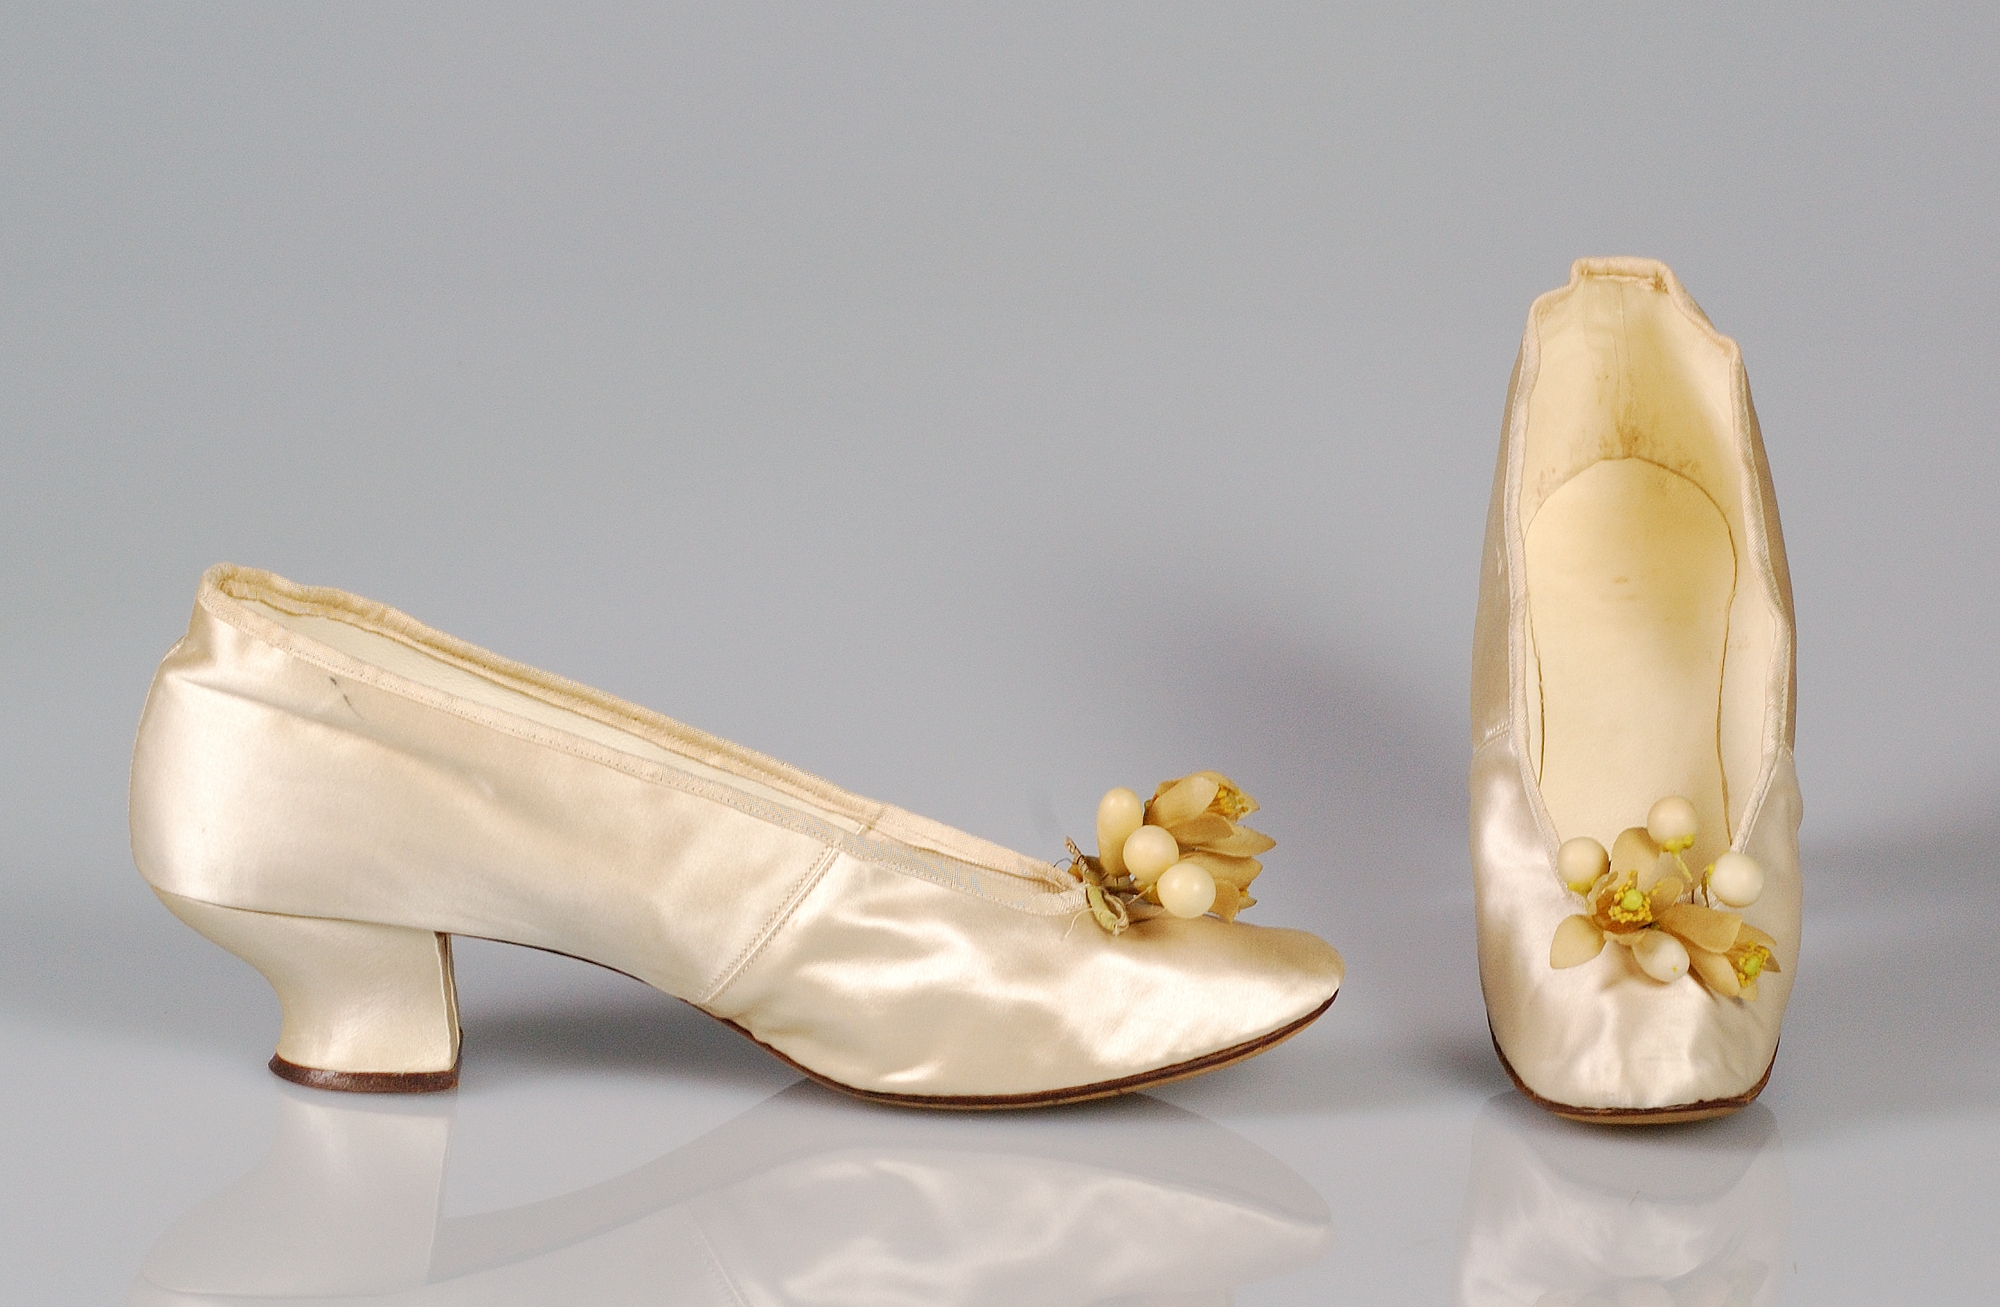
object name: wedding slipper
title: Wedding slippers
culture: american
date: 1886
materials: silk, wax